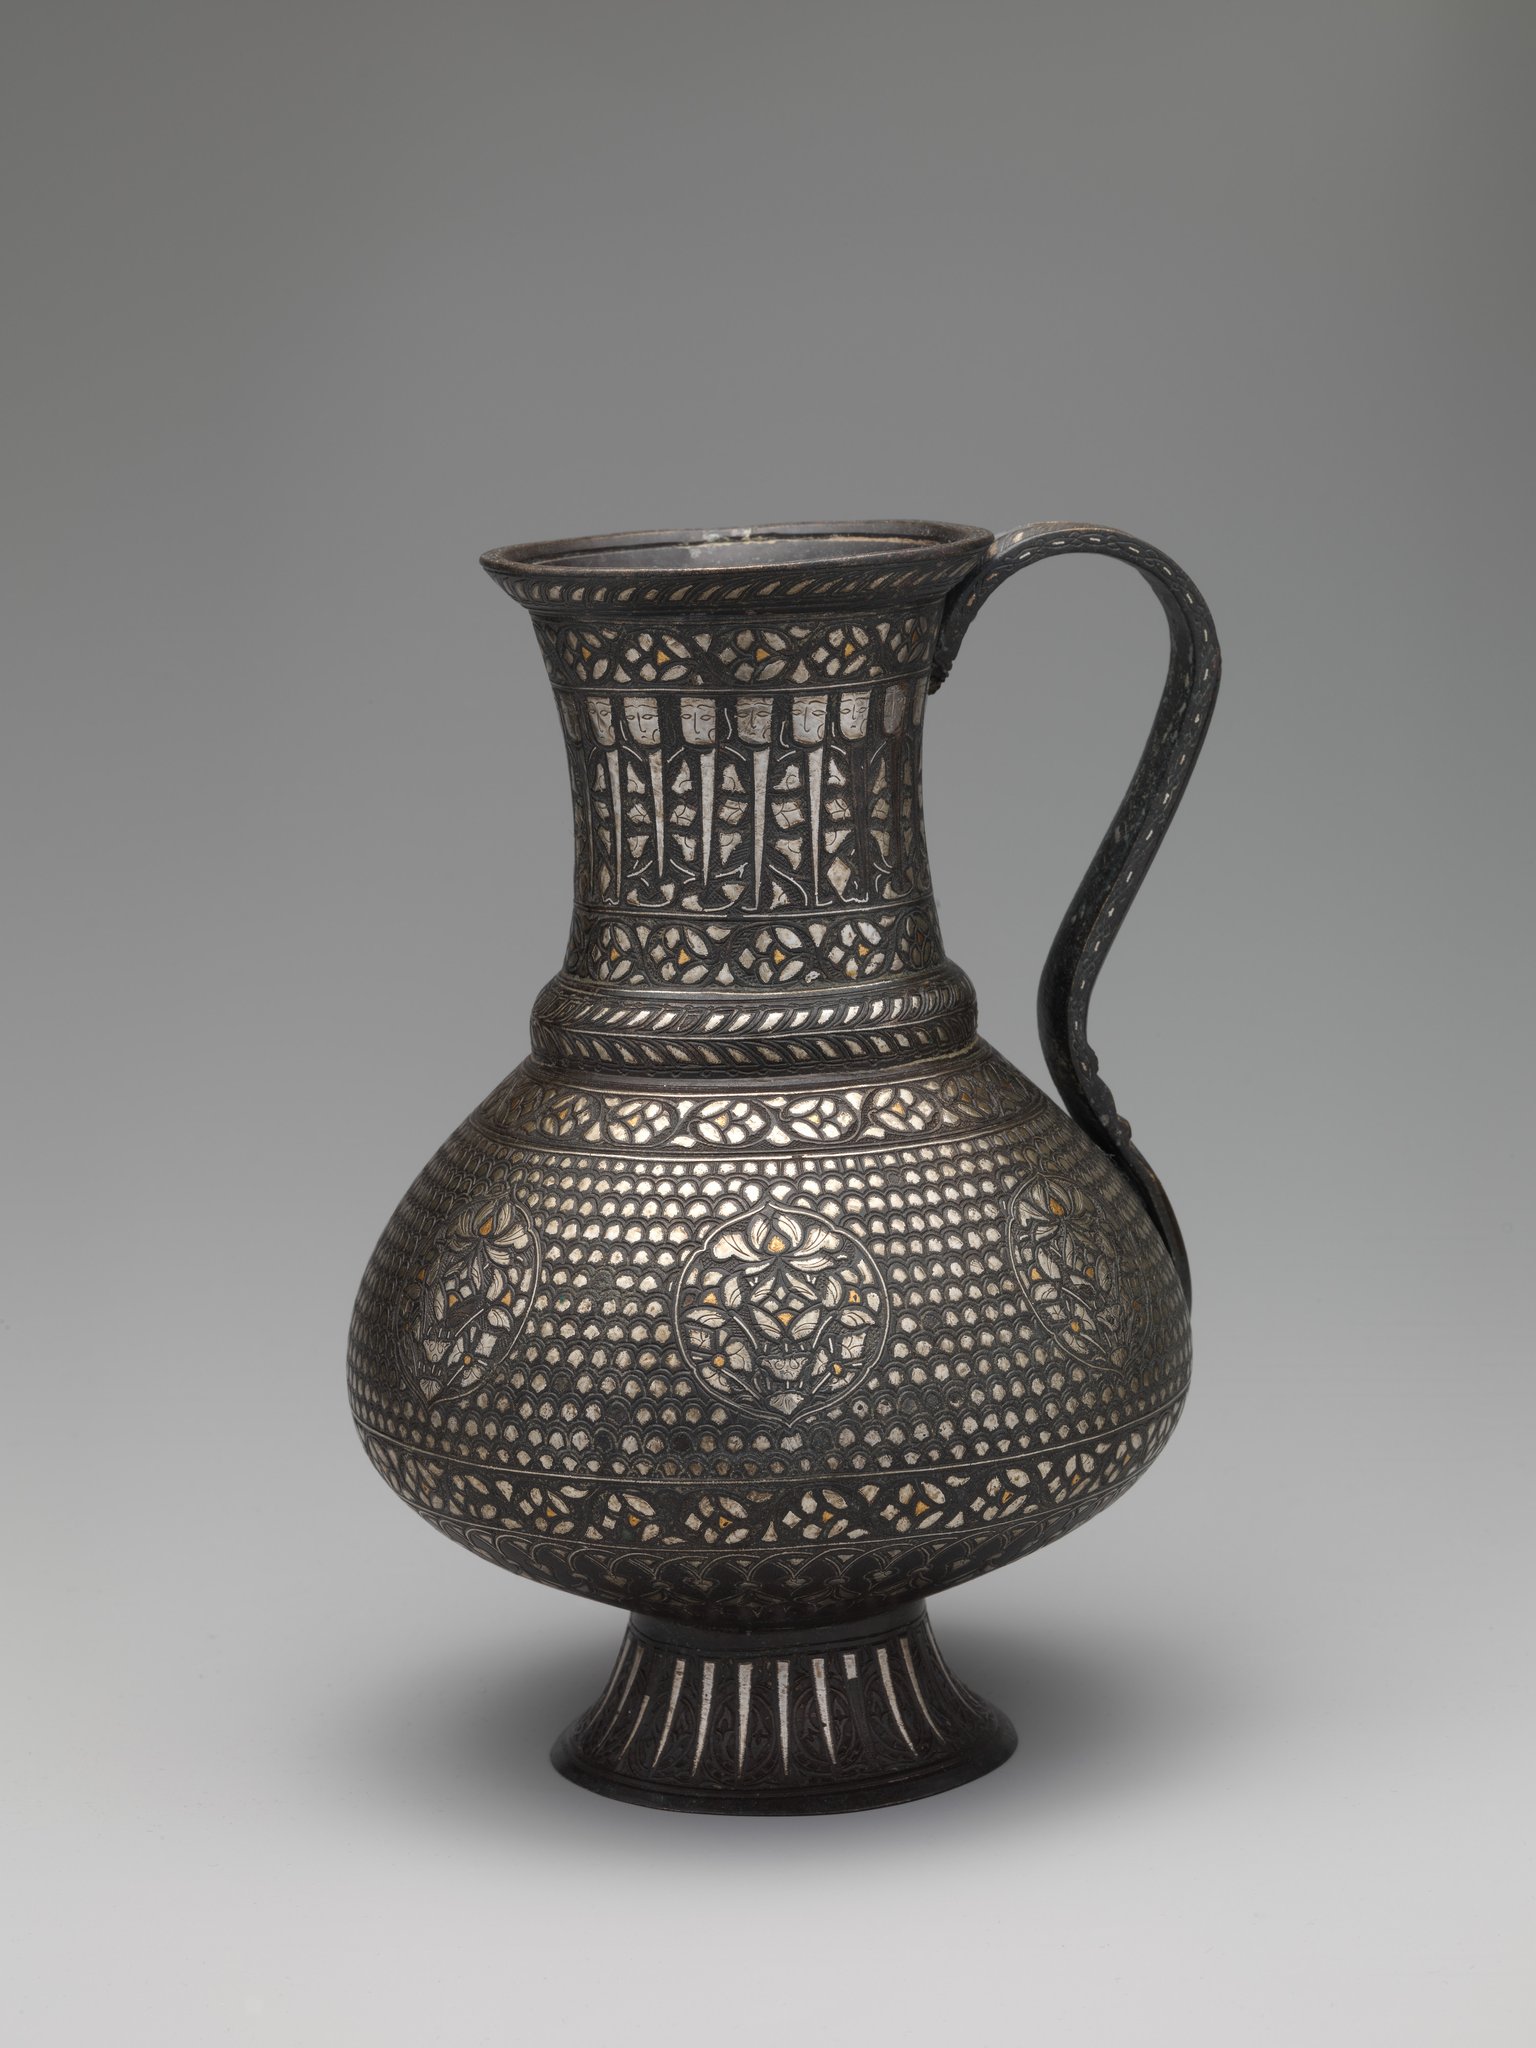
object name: ewer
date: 1251-1300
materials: bronze, gold, silver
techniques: casting, chasing, engraving, inlay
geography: iran